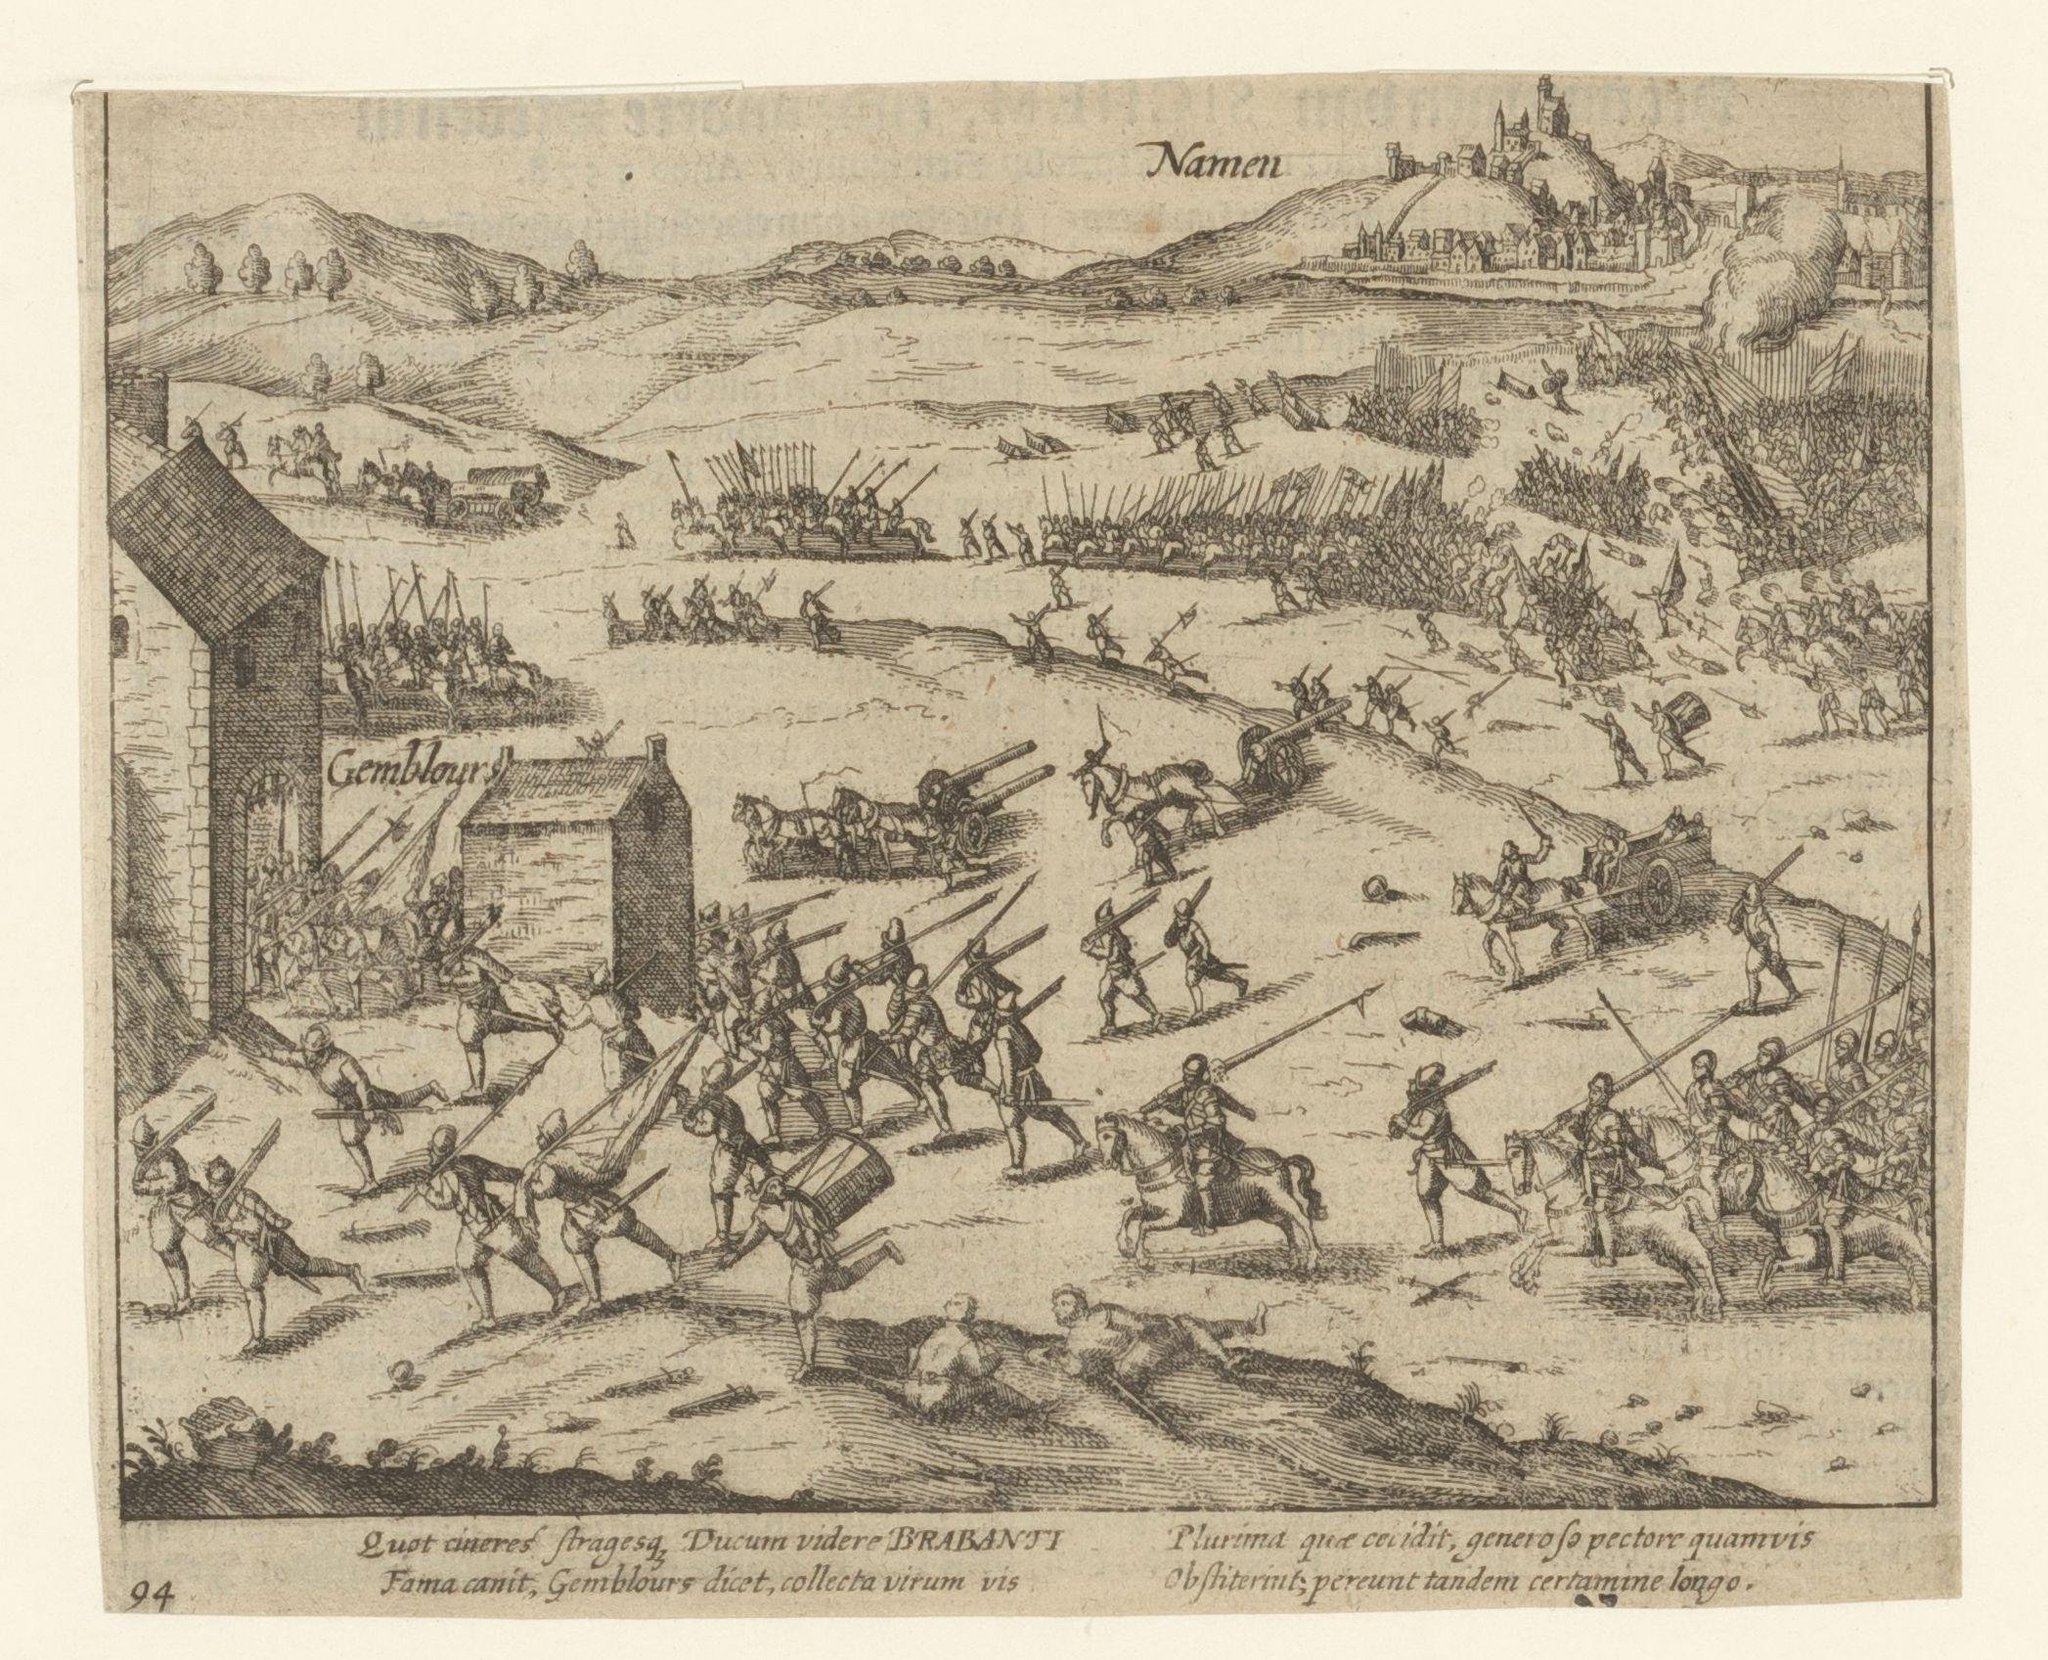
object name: book illustration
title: Slag bij Gembloers, 1578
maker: Anonymous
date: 1613-1615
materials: paper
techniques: etching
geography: northern netherlands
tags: battle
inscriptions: collector's mark, collector's mark: Lugt 1641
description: Deze platen genomen uit: W. Baudartius, De Nassausche oorloghen. Afbeeldinghe, ende beschrijvinghe van alle de veldslagen, belegeringen, ende and're notable geschiedenissen, ghevallen in de Nederlanden, geduerende d'oorloghe teghens de Coningh van Spaengien, onder het beleydt van den Prince van Oraengien, ende Prince Maurits de Nassau, etc. Amsterdam: Michiel Colijn, 1615.